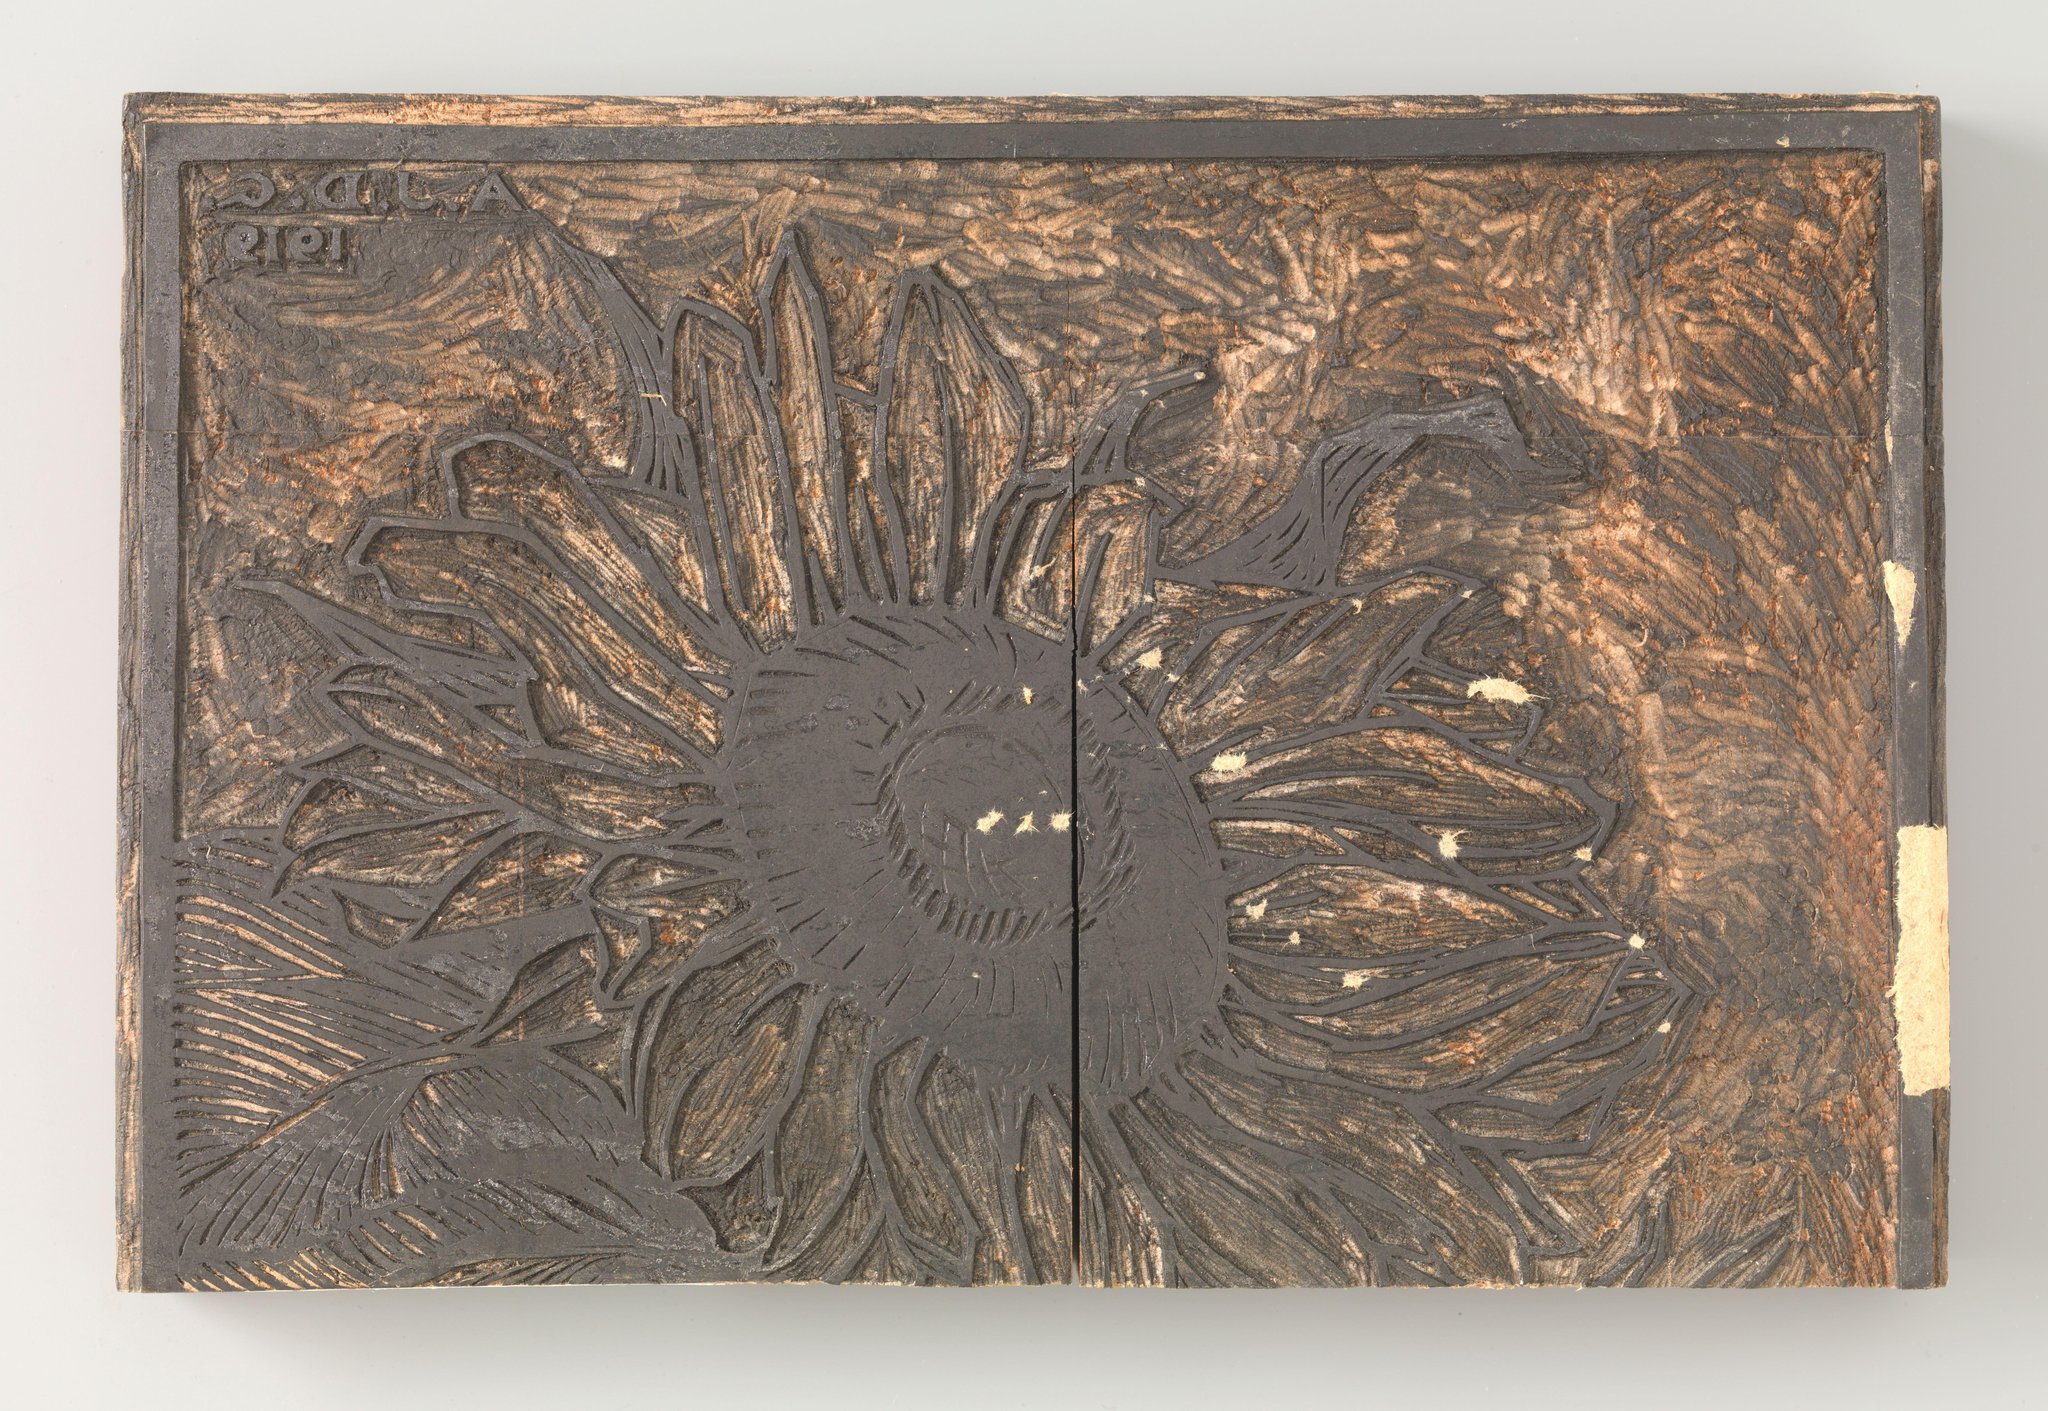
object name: wood block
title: Zonnebloem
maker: julie de graag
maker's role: draughtsman, print maker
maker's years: 1877-1924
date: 1919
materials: wood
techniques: woodcut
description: Slechts de bovenste helft van de zonnebloem is bewaard, omdat het blok is doorgezaagd.